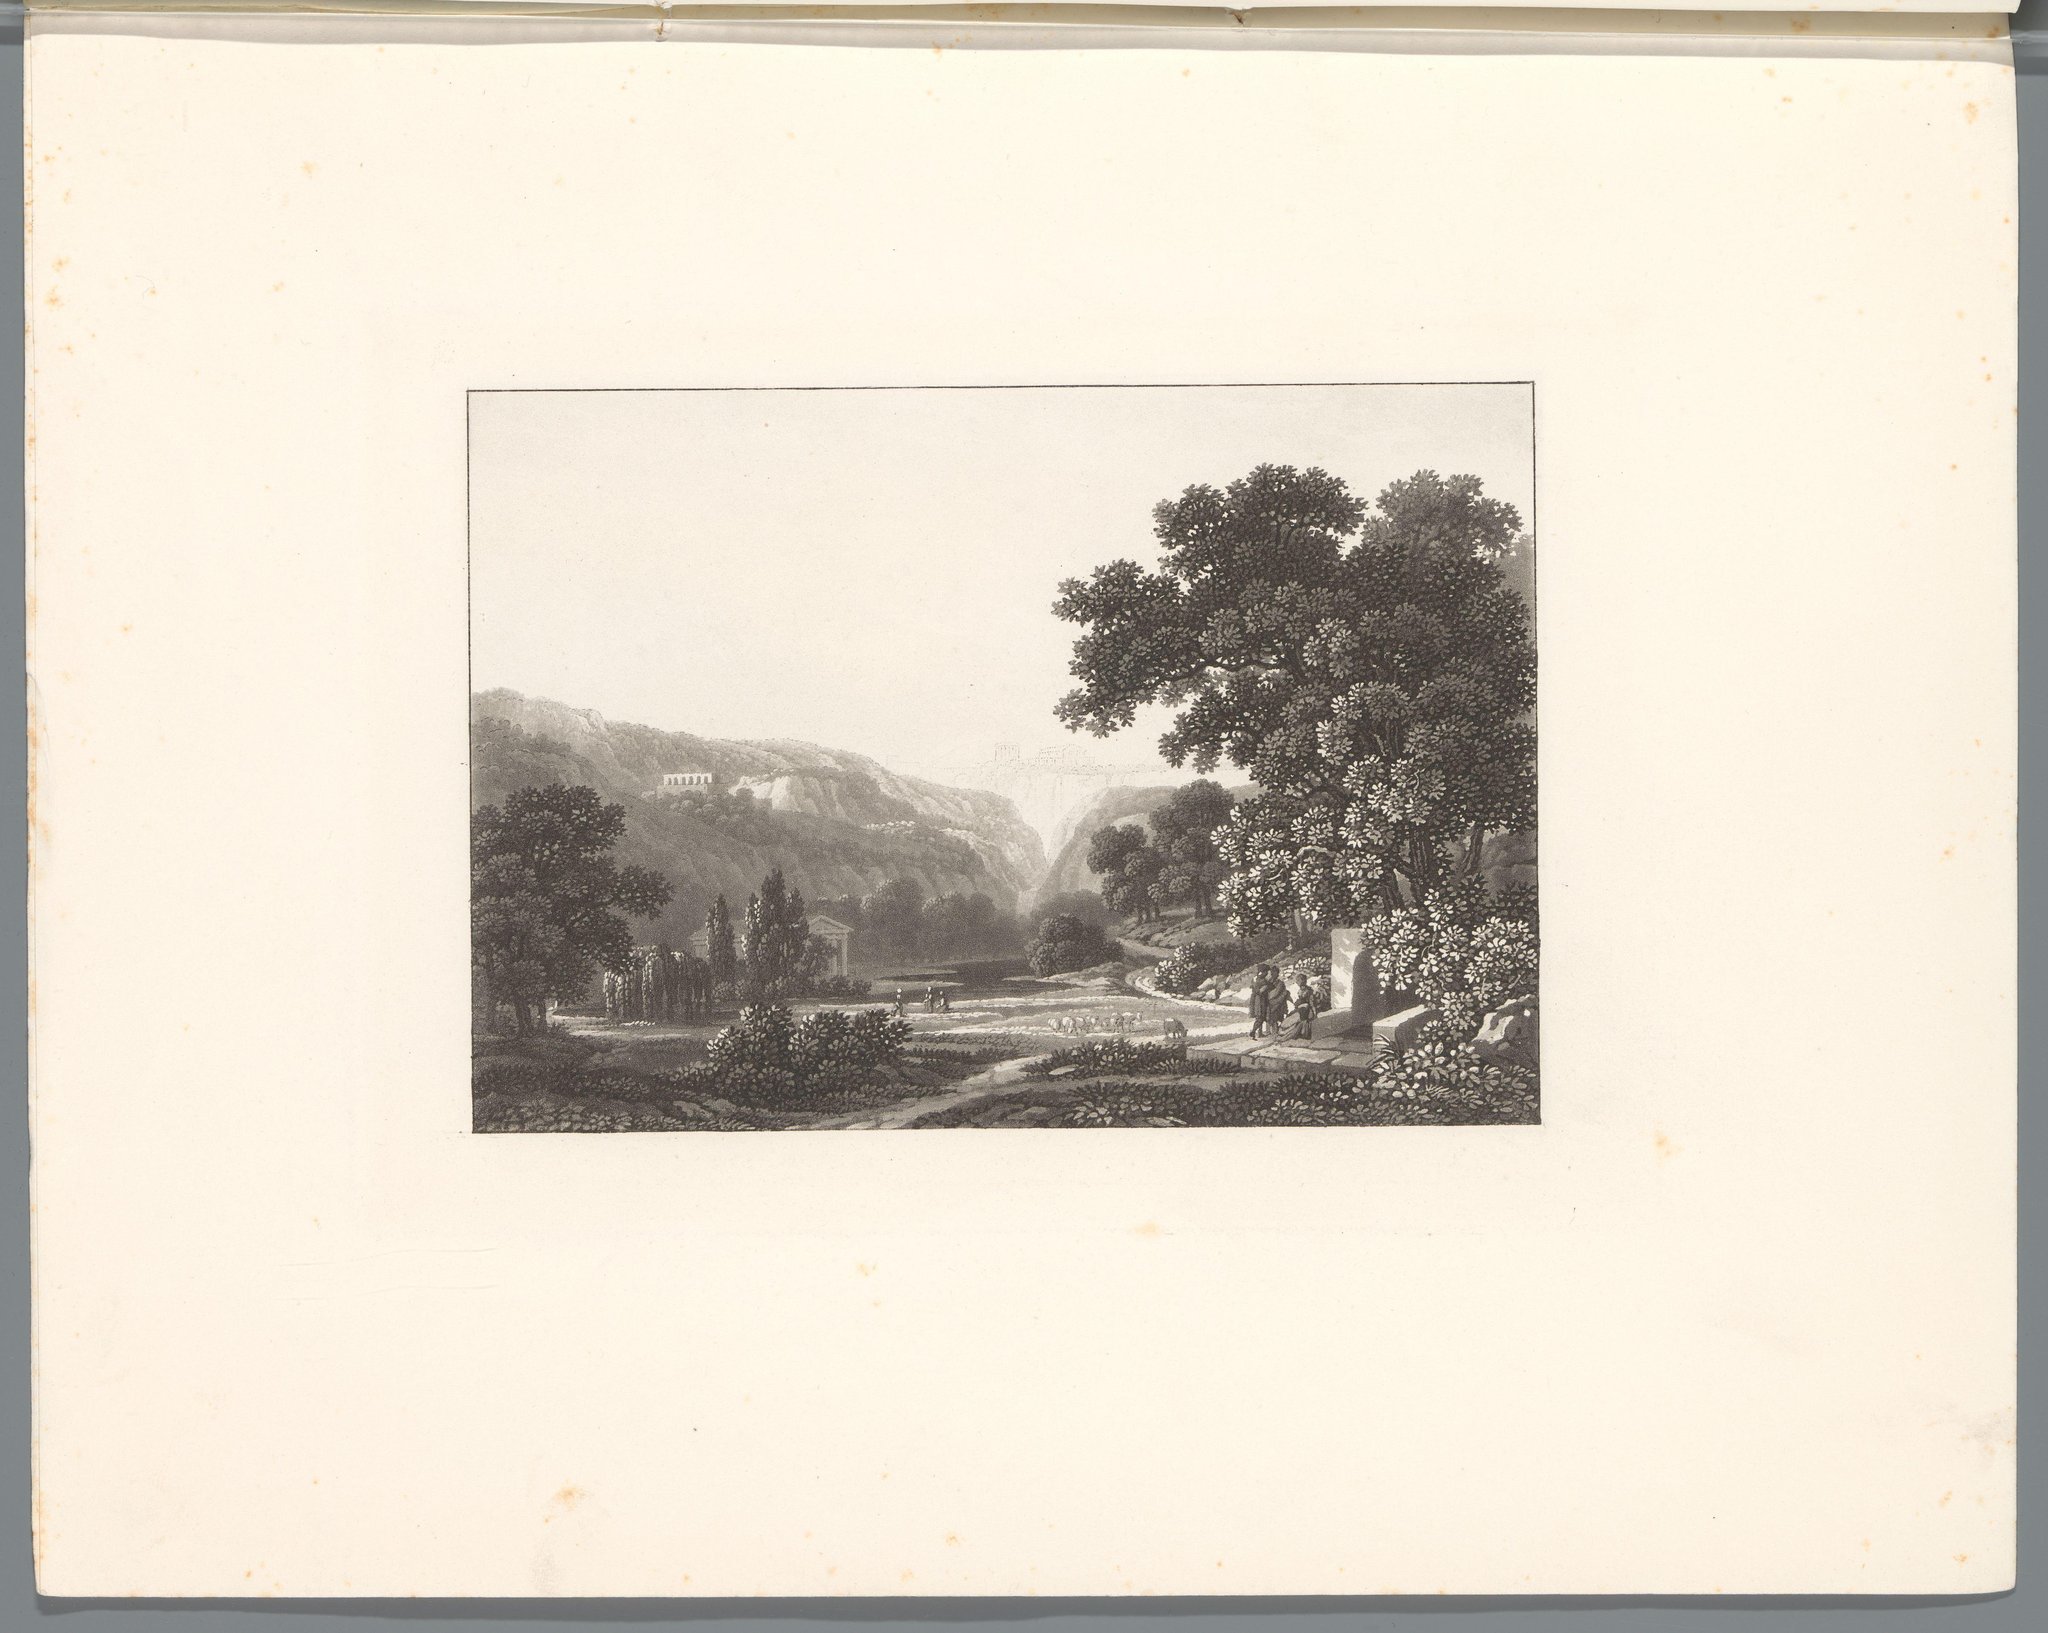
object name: print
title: Heuvellandschap met antieke bouwwerken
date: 1804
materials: paper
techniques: aquatint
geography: karlsruhe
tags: low hill country (+ landscape with figures, staffage)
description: Prent uit: Haldenwang, Christian. 6 Landschaftliche Entwürfe nach Wehle in Aqua tinta geätzt vom C. Haldenwang. Karlsruhe: Franz Nöldeke, [1804].